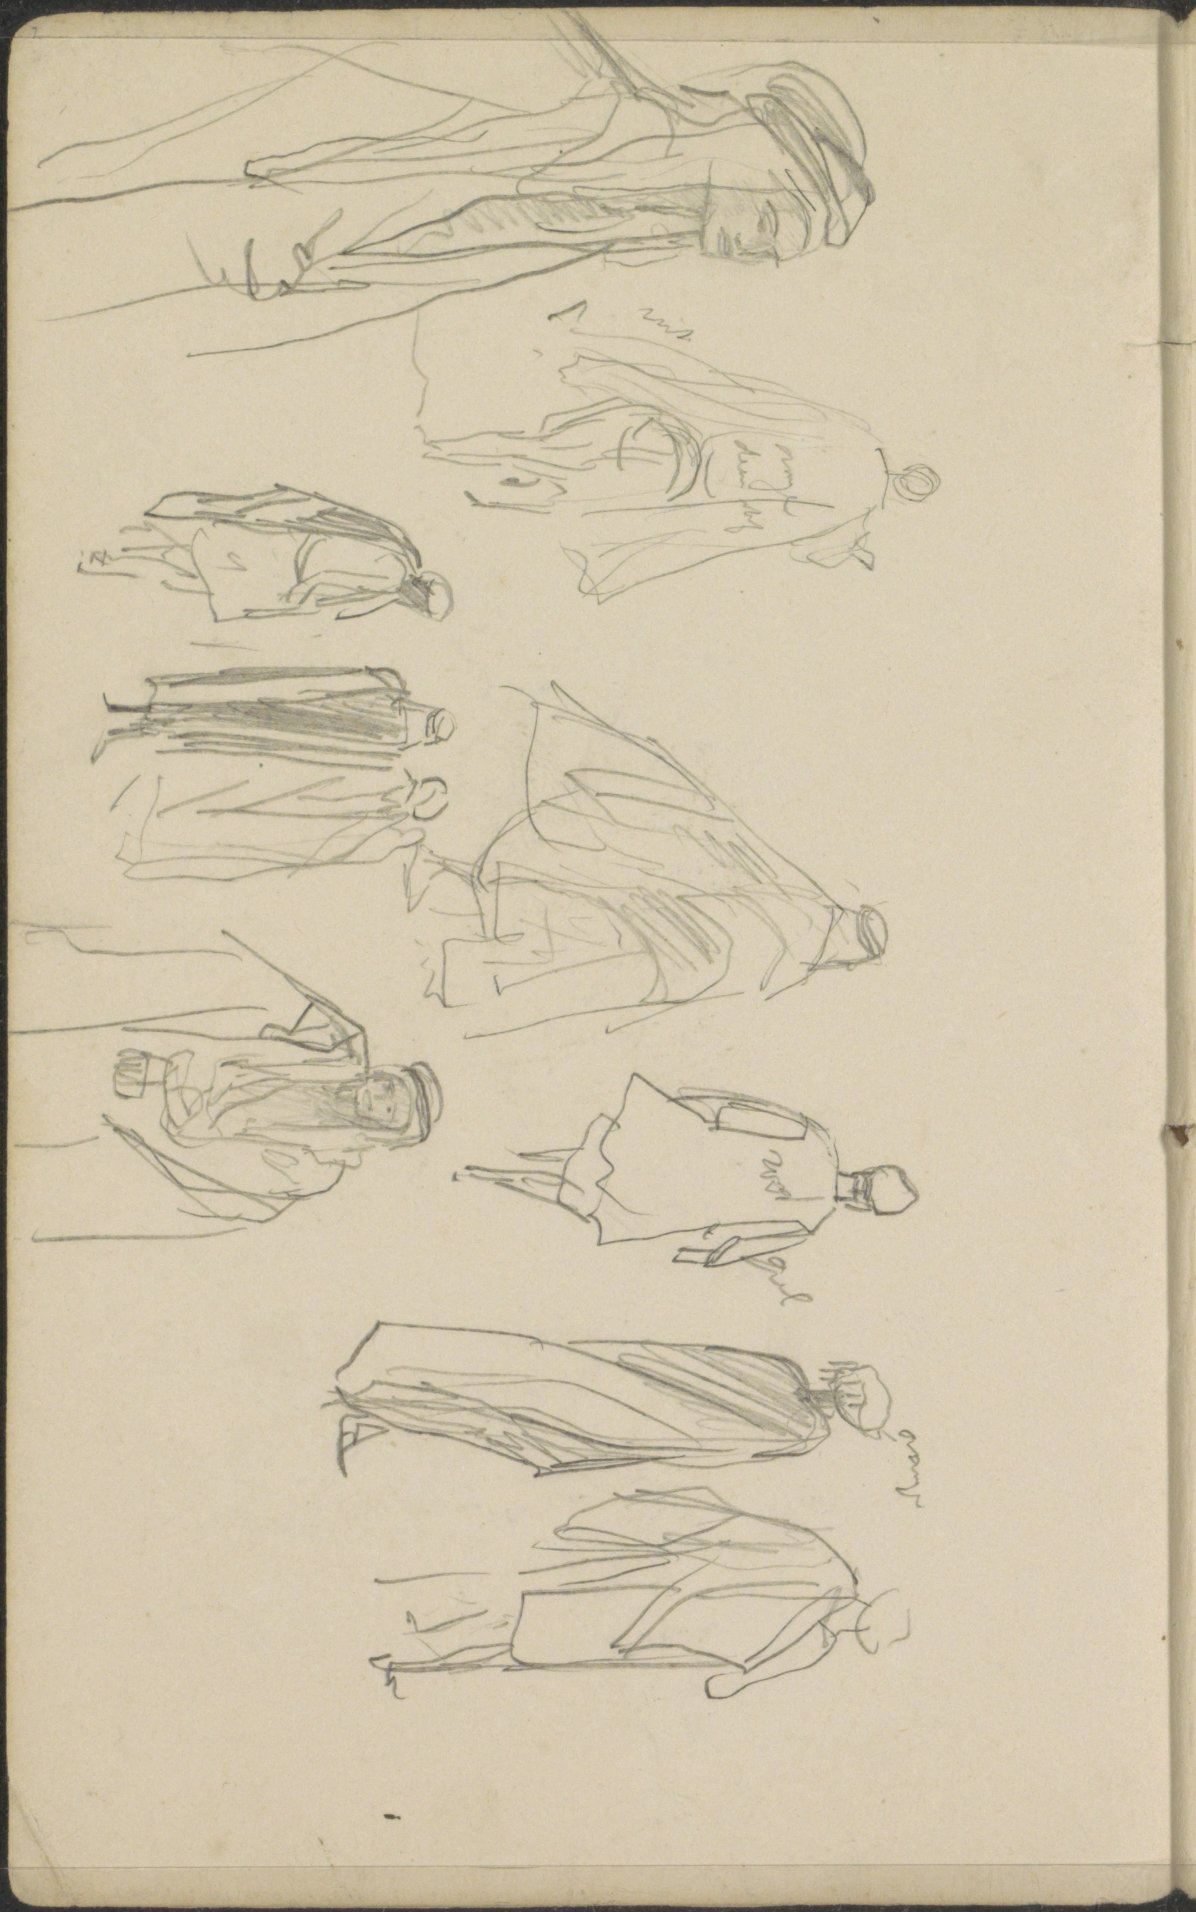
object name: sketchbook leaf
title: Arabieren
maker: marius bauer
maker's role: draughtsman, print maker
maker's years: 1867-1932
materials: paper, pencil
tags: africans, folk costume, regional costume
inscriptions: kleurnotitie, handgeschreven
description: De figuren dragen traditioneel kostuum. Pagina 2 uit een schetsboek met 36 bladen.